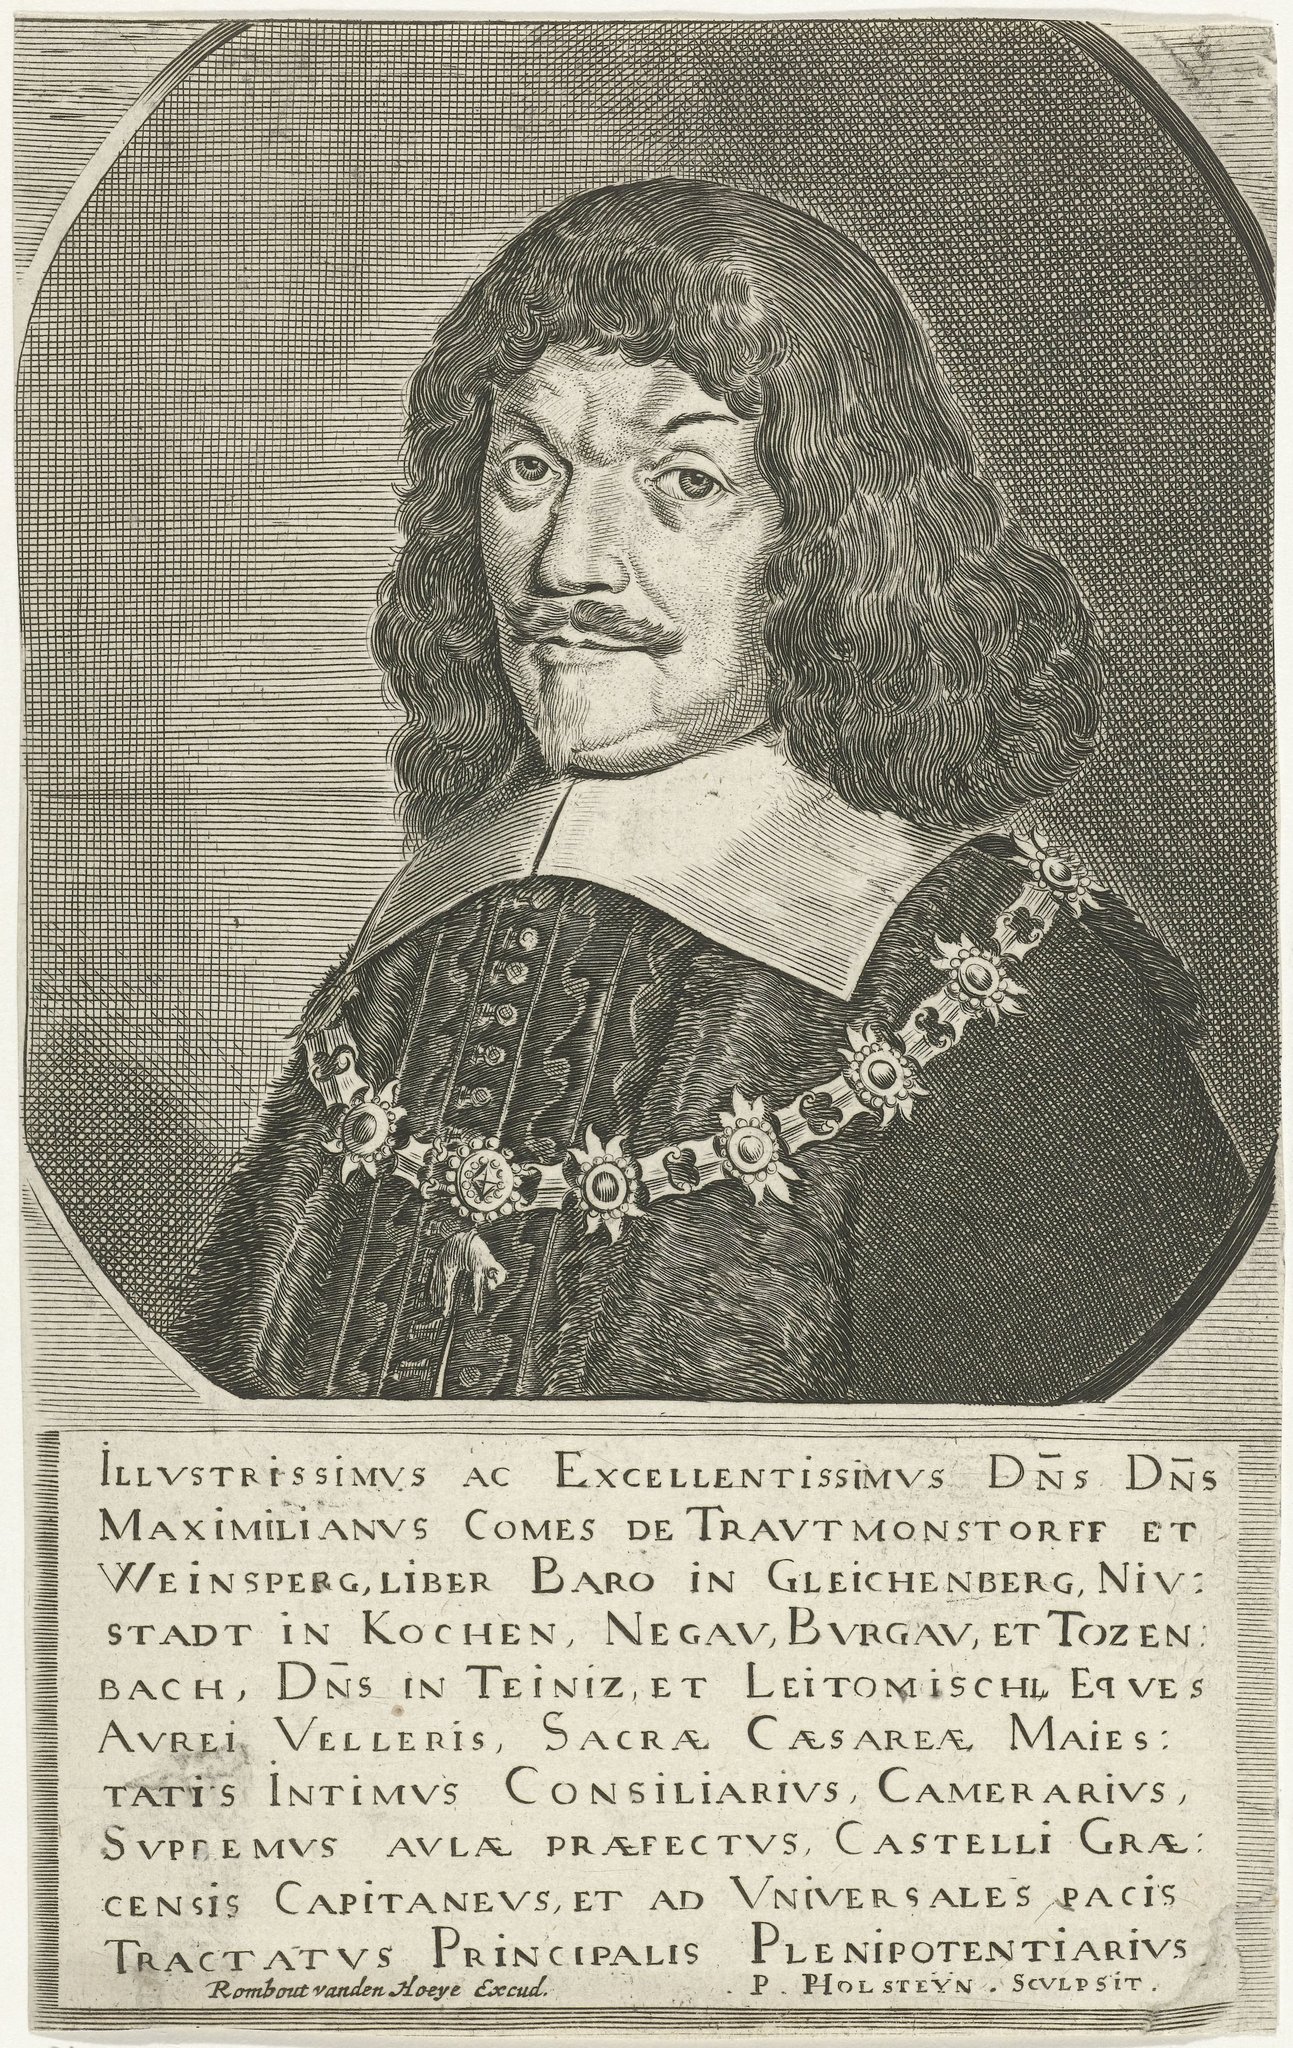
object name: print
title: Portretten van ambassadeurs van de Vrede van Munster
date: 1648-1670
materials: paper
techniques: engraving, etching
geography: amsterdam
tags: maximiliaan (graaf van trauttmansdorff), vrede van münster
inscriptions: collector's mark: Lugt 2228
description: Buste naar links van Maximiliaan, graaf van Trauttmansdorff. Onder het portret tien regels in het Latijn. Prent uit een serie portretten van ambassadeurs betrokken bij het vredesverdrag van Munster.